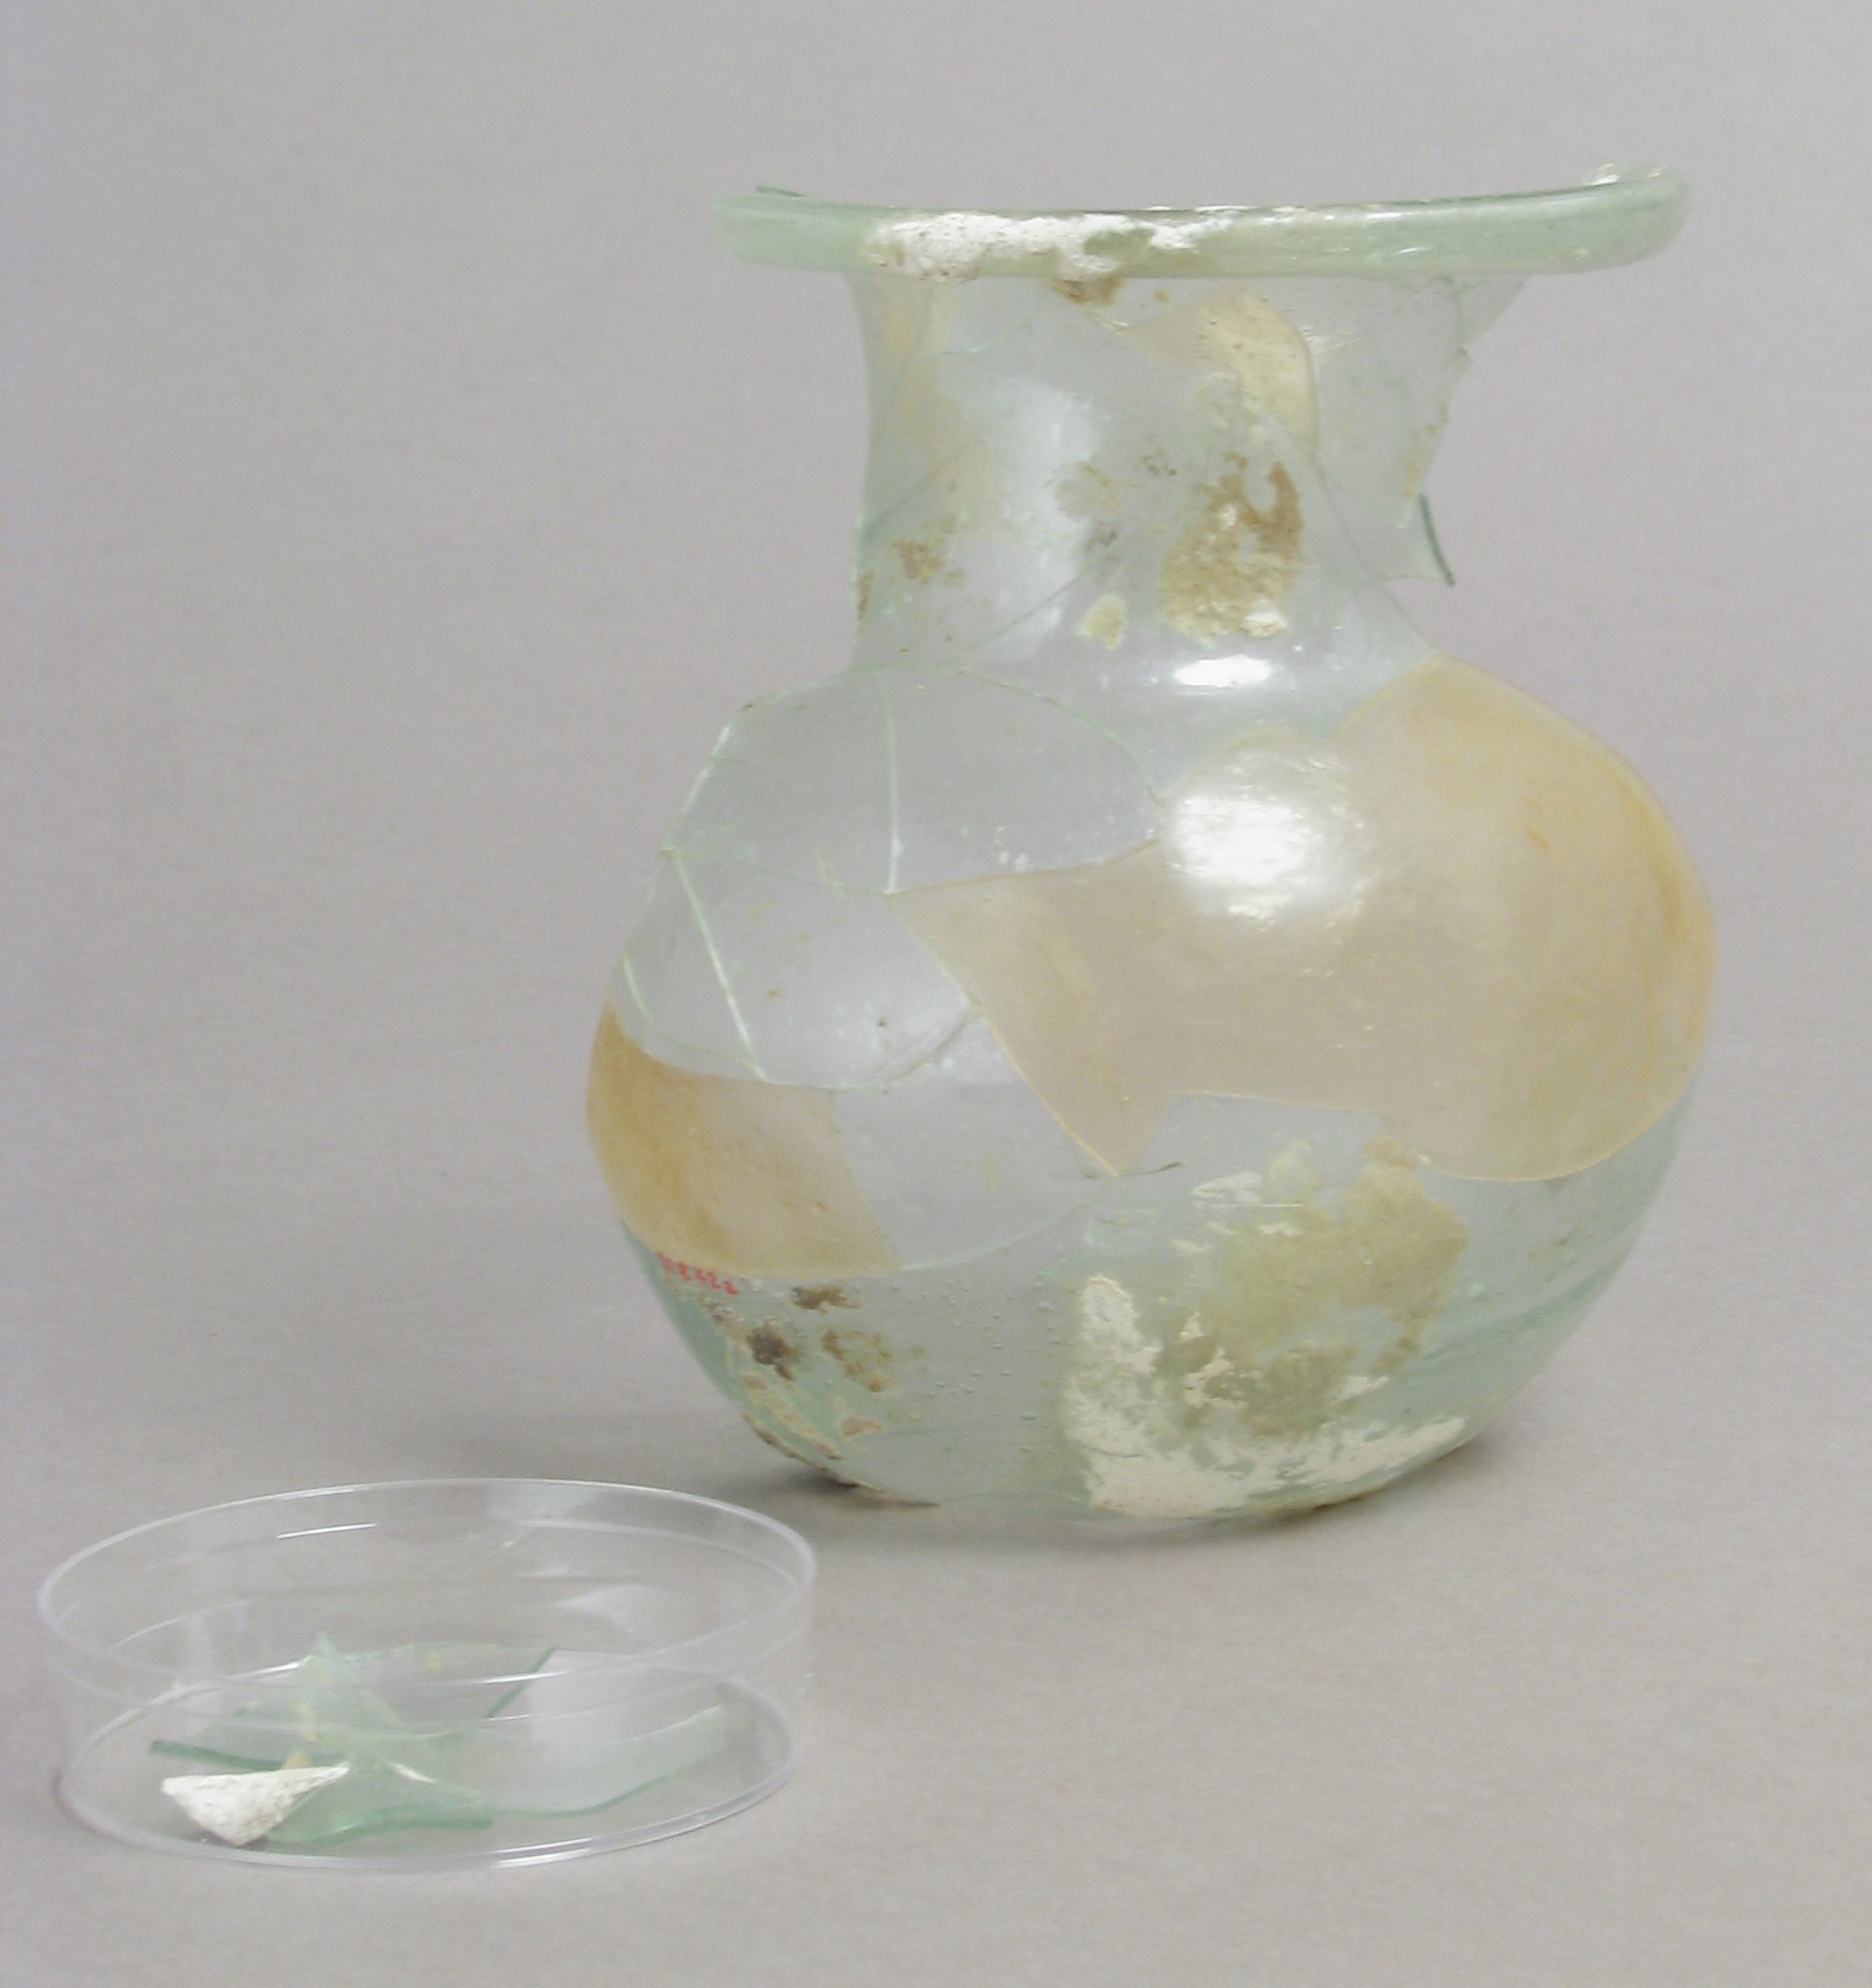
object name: fragment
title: Glass Fragments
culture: coptic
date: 301-400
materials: glass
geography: egypt